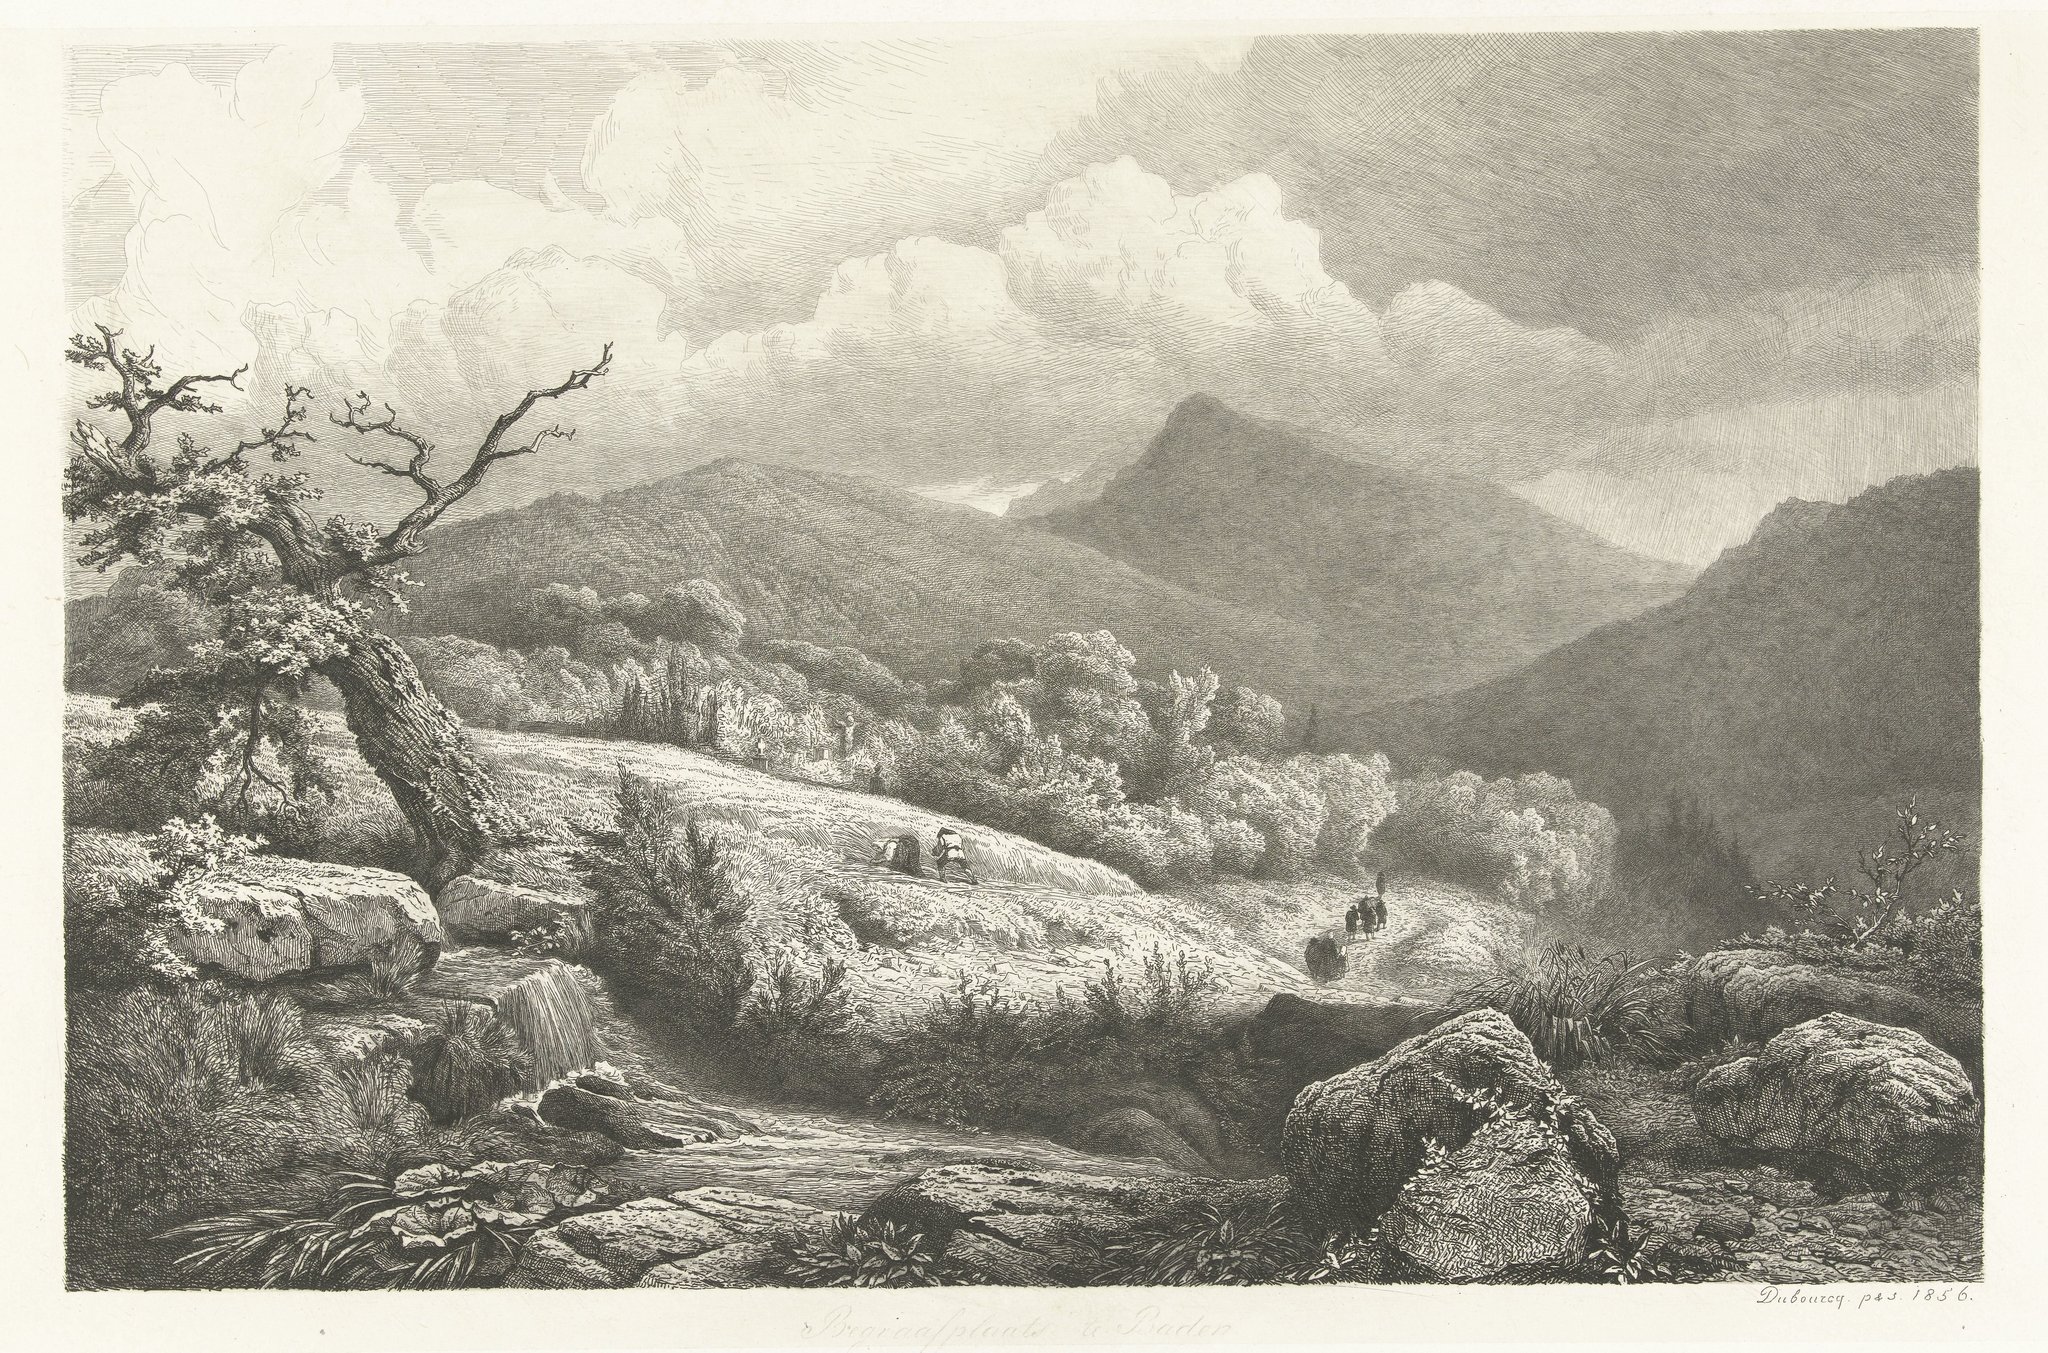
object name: print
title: De begraafplaats te Baden-Baden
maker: pierre louis dubourcq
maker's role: draughtsman, painter, print maker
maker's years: 1815-1873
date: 1856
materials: paper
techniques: etching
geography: netherlands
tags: landscape with other man-made constructions not mentioned above, e.g.: graveyards, playgrounds, etc.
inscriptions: collector's mark: Lugt 2228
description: De begraafplaats te Baden-Baden. Berglandschap met een kleine begrafenisstoet op weg naar de begraafplaats links tussen de bomen. Op de voorgrond een waterval.